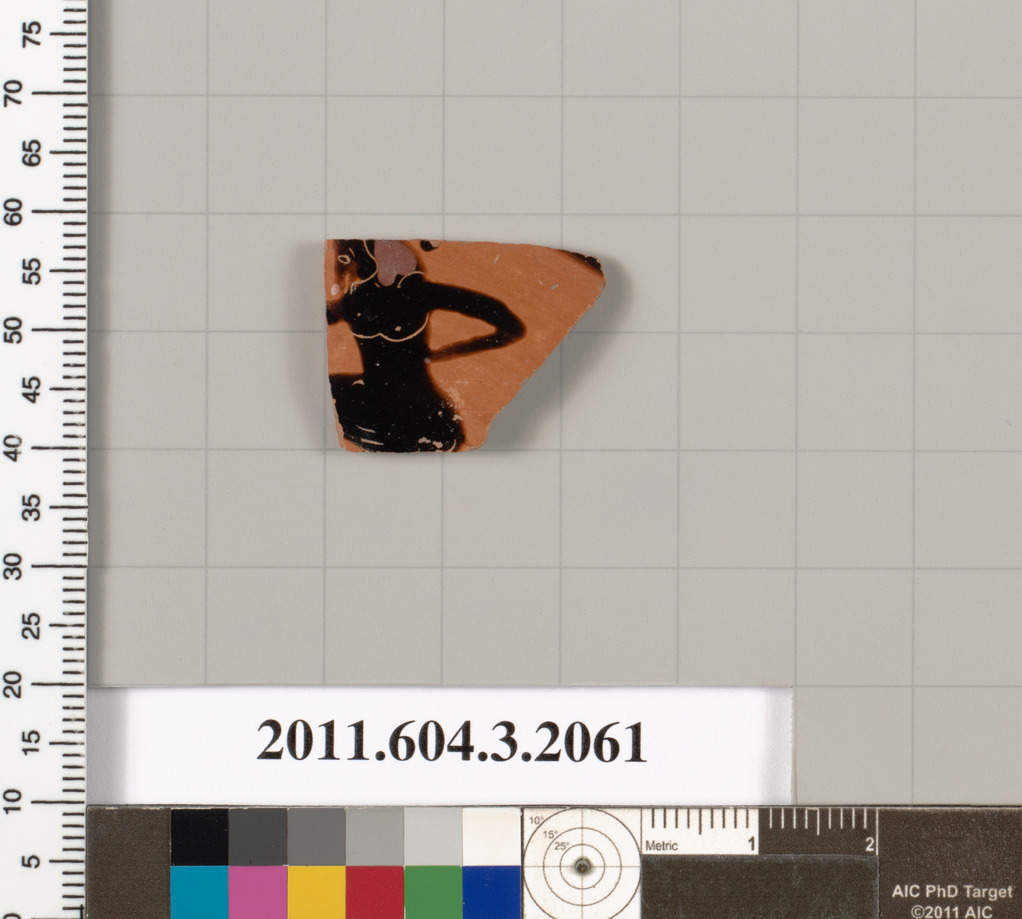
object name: kylix fragment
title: Terracotta fragment of a kylix (drinking cup)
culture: greek, attic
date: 534-468 BCE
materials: terracotta